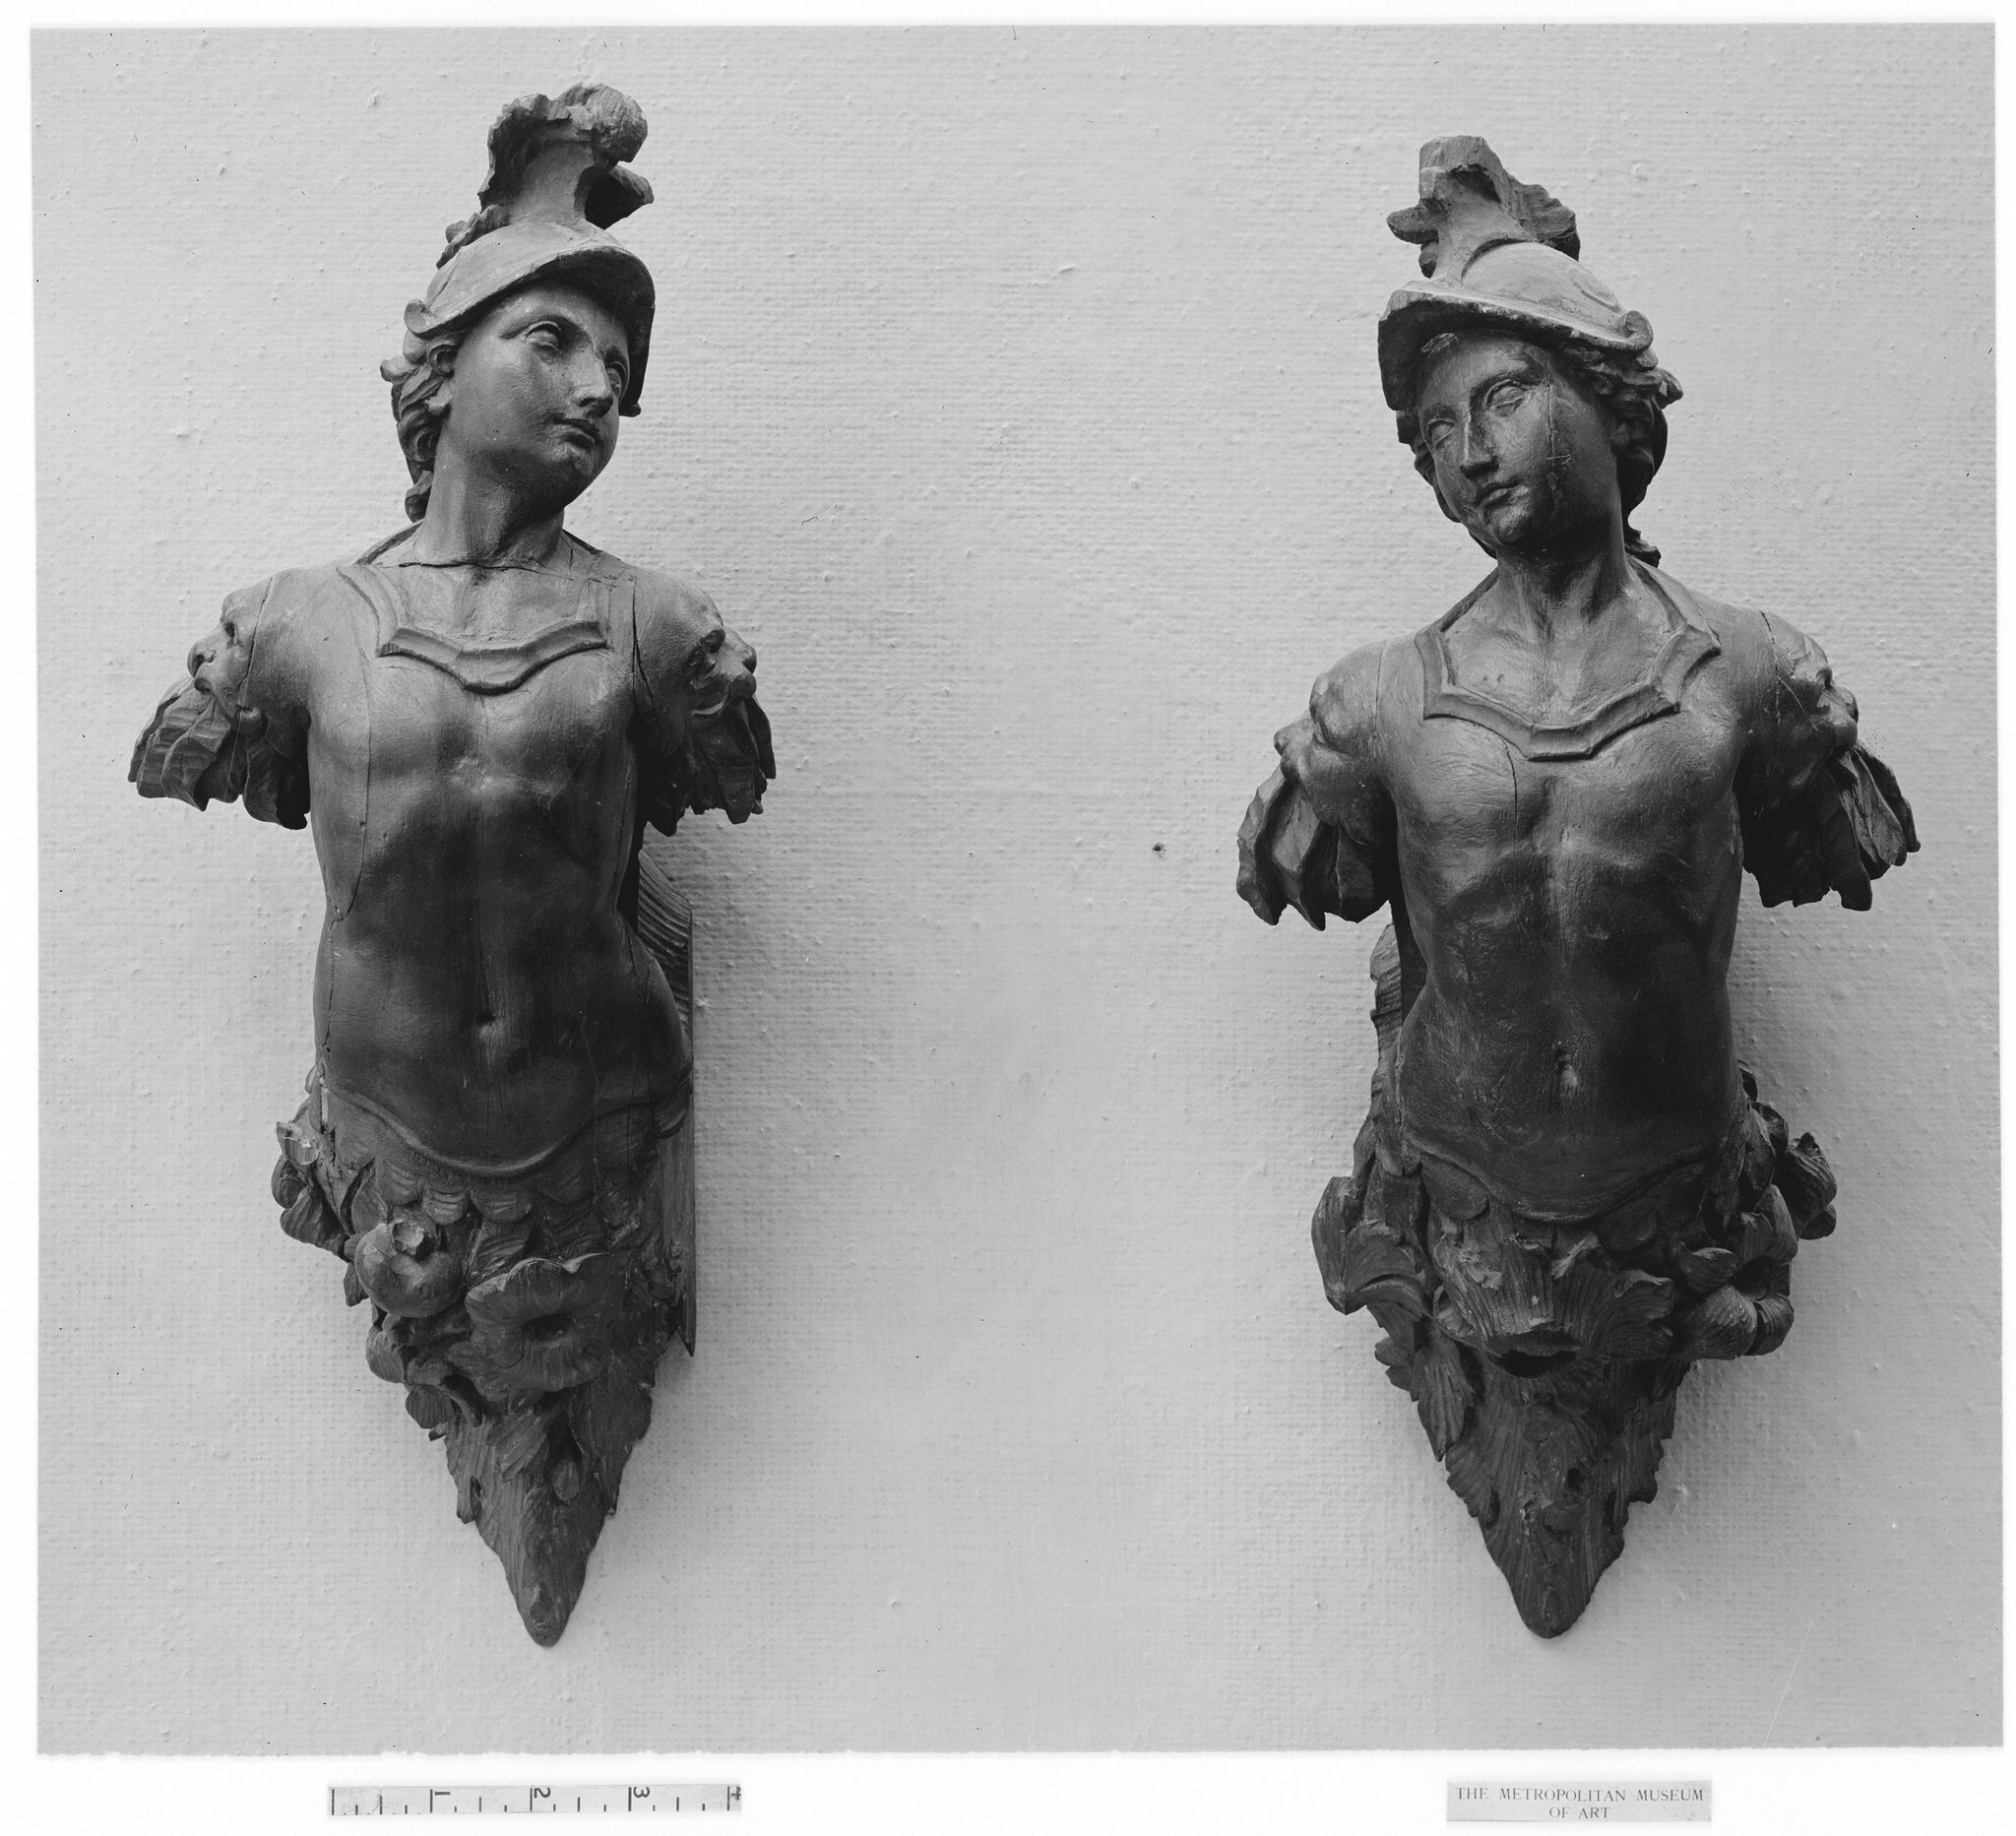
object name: terminal statuette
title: Pair of terminal statuettes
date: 1701-1750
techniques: gilding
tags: men